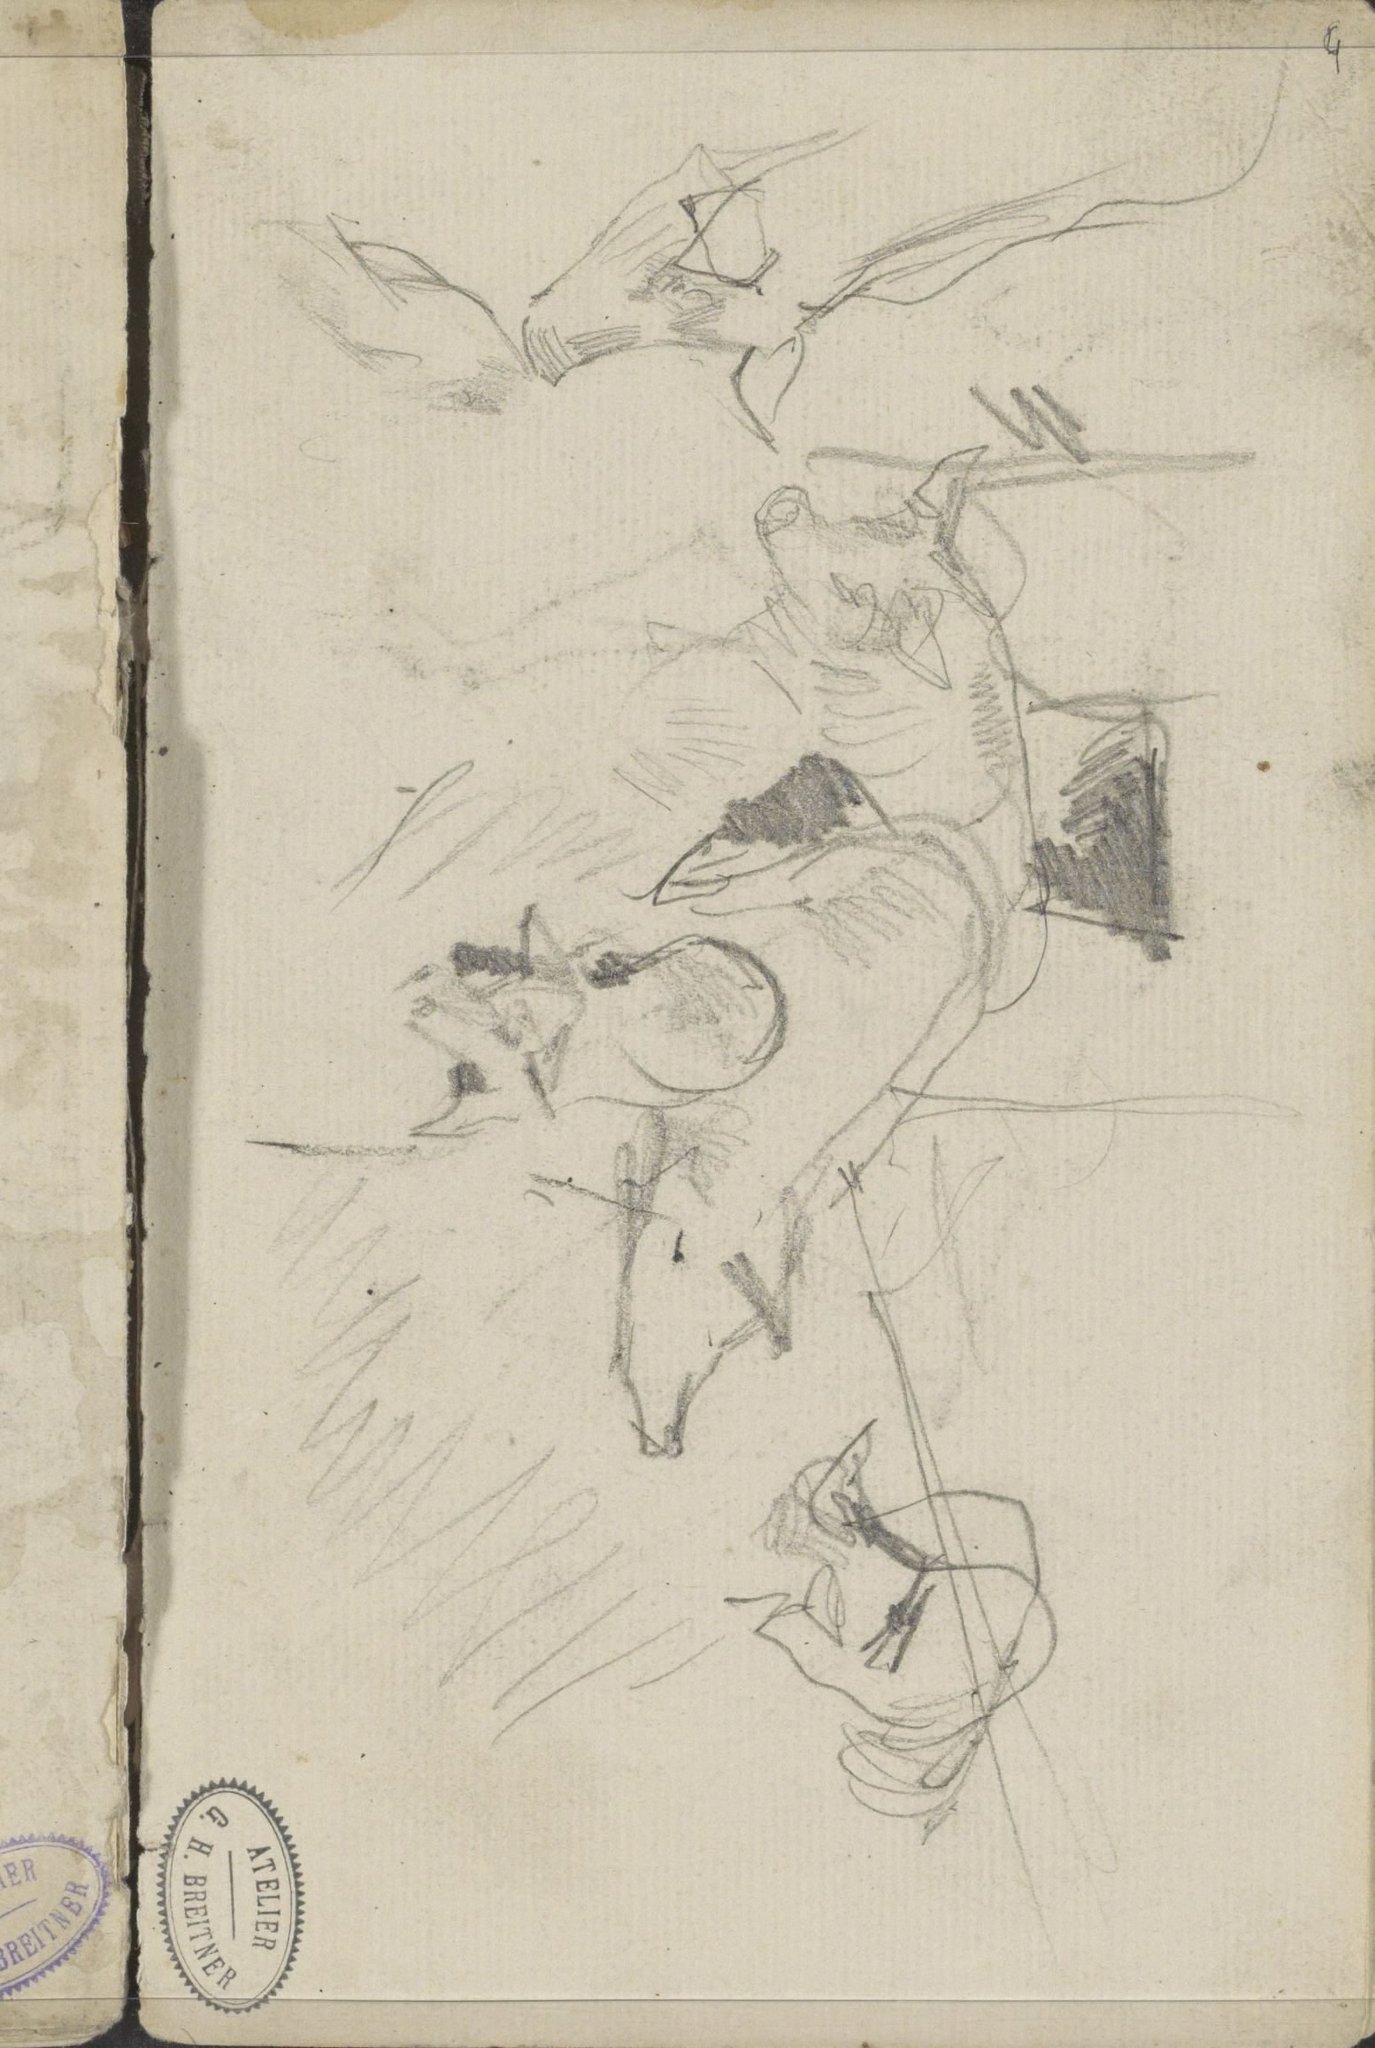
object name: sketchbook leaf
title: Varkens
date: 1880-1882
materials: paper, pencil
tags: pig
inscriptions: workshop stamp: Lugt 291d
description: Pagina G, los aangetroffen tussen blad 33 en het achterste schutblad in een schetsboek met 16 bladen.